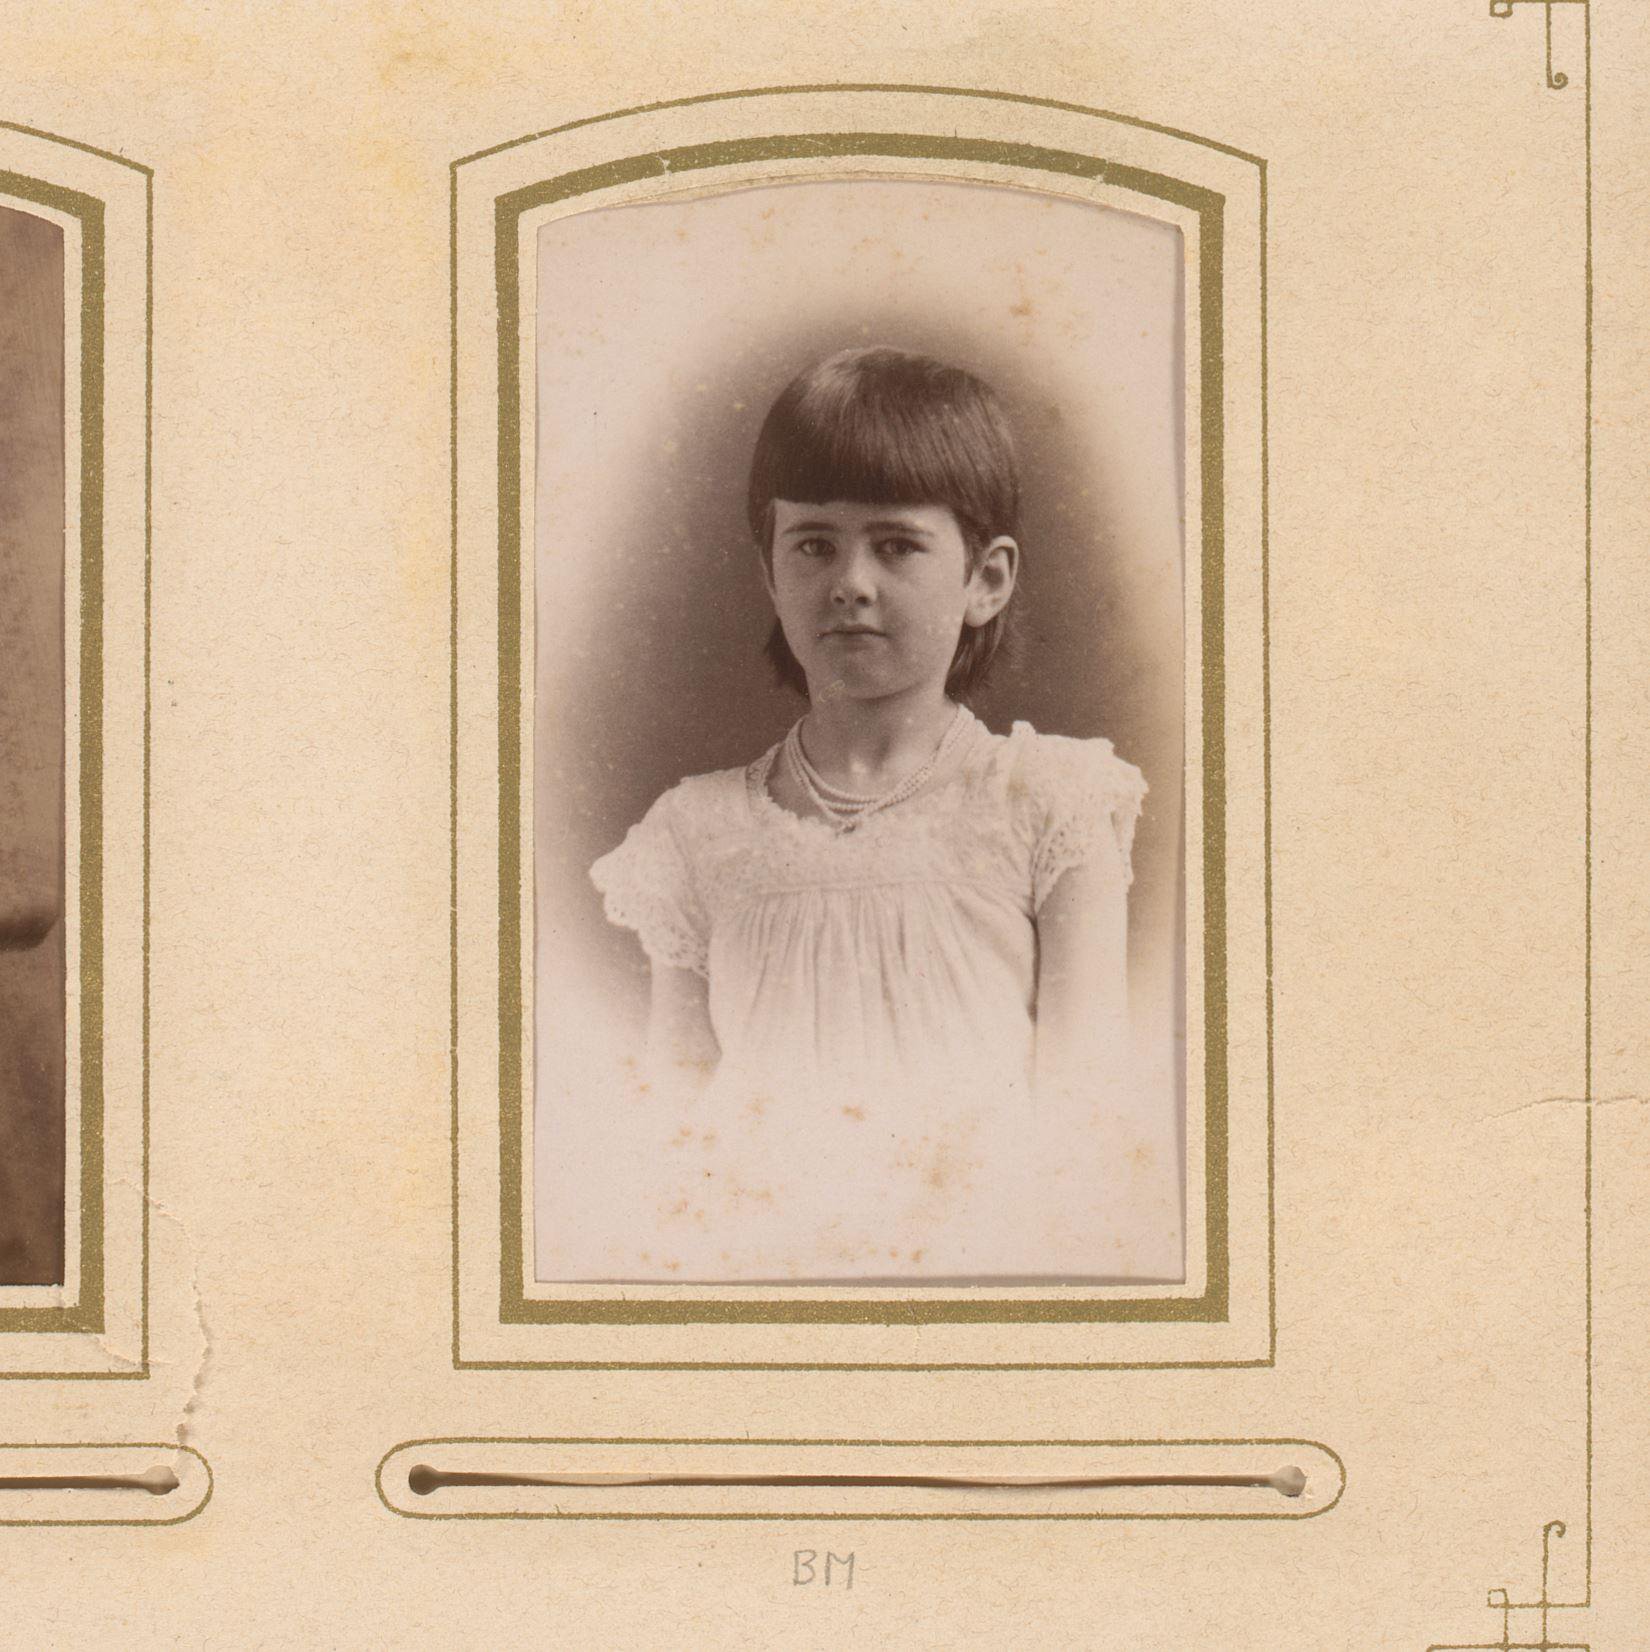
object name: album leaf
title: Portret van een meisje met halskettingen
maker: Anonymous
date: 1860-1900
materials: cardboard, photographic support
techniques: albumen print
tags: historical persons - bb - woman, girl (child between toddler and youth), necklace